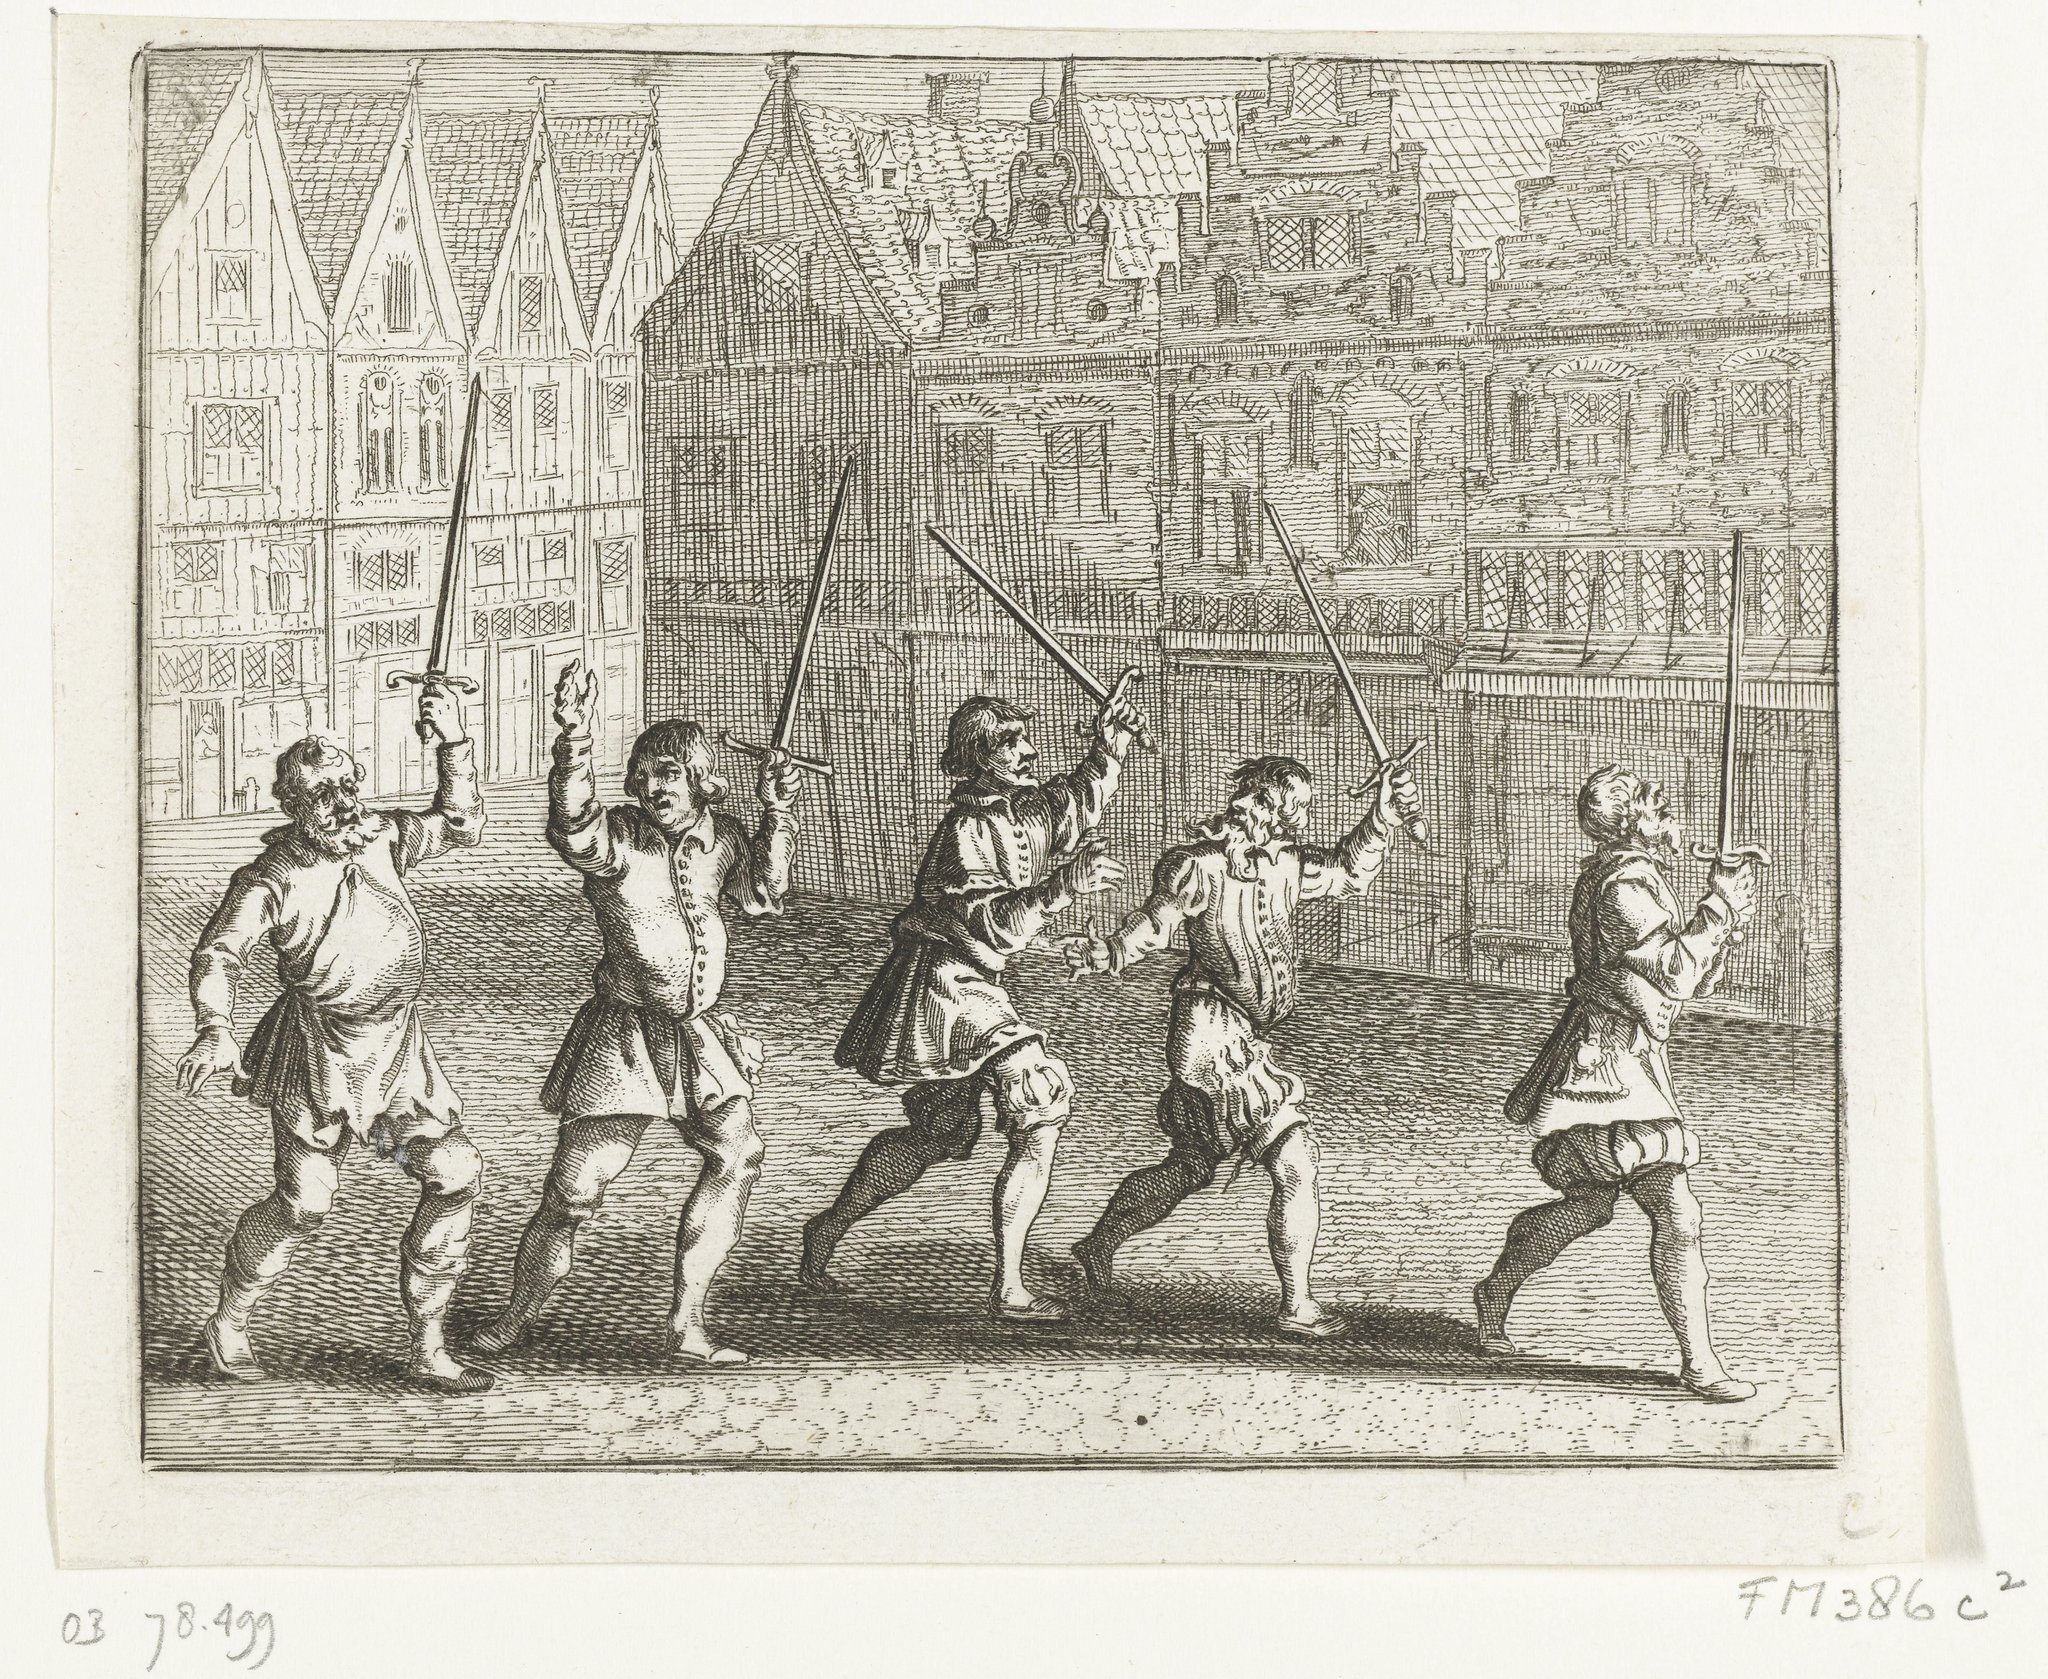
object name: history print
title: Zwaardlopers te Amsterdam, 1534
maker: Anonymous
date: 1662-1665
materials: paper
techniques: engraving, etching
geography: northern netherlands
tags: amsterdam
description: Gebruikt als illustratie in: T. van Domselaer, Beschryvinge van Amsterdam, Marcus Willemsz Doornick, Amsterdam 1665, VI. Boeck, p. 166. Deze prenten zijn gebaseerd op de anonieme gravures in de eerste uitgave Hortensius' Van den oproer der weder-dooperen uit 1614. Kopieën naar FMH 386, Niet in Frederik Muller; door het RPK toegevoegd nummer. Naar het verloren gegane schilderij van Barend Dircksz. in het oude stadhuis te Amsterdam.